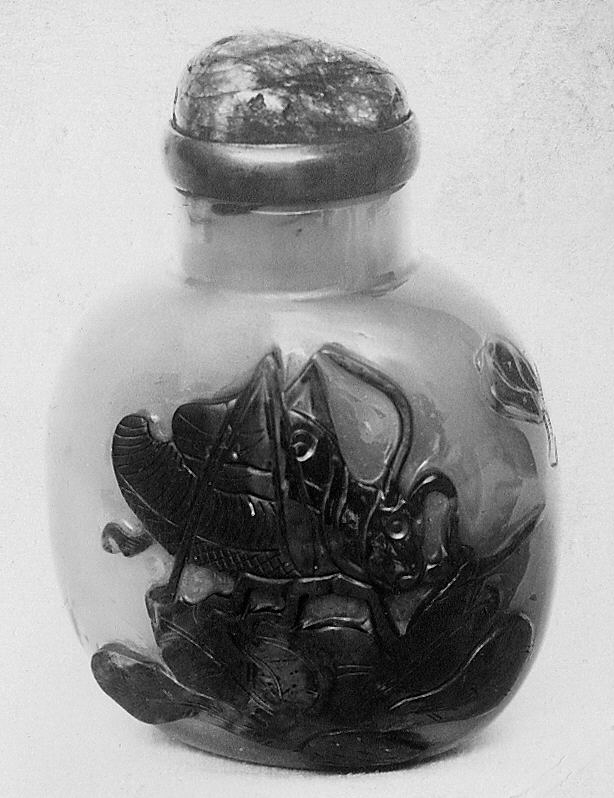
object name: snuff bottle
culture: chinese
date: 1736-1795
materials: stone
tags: insects